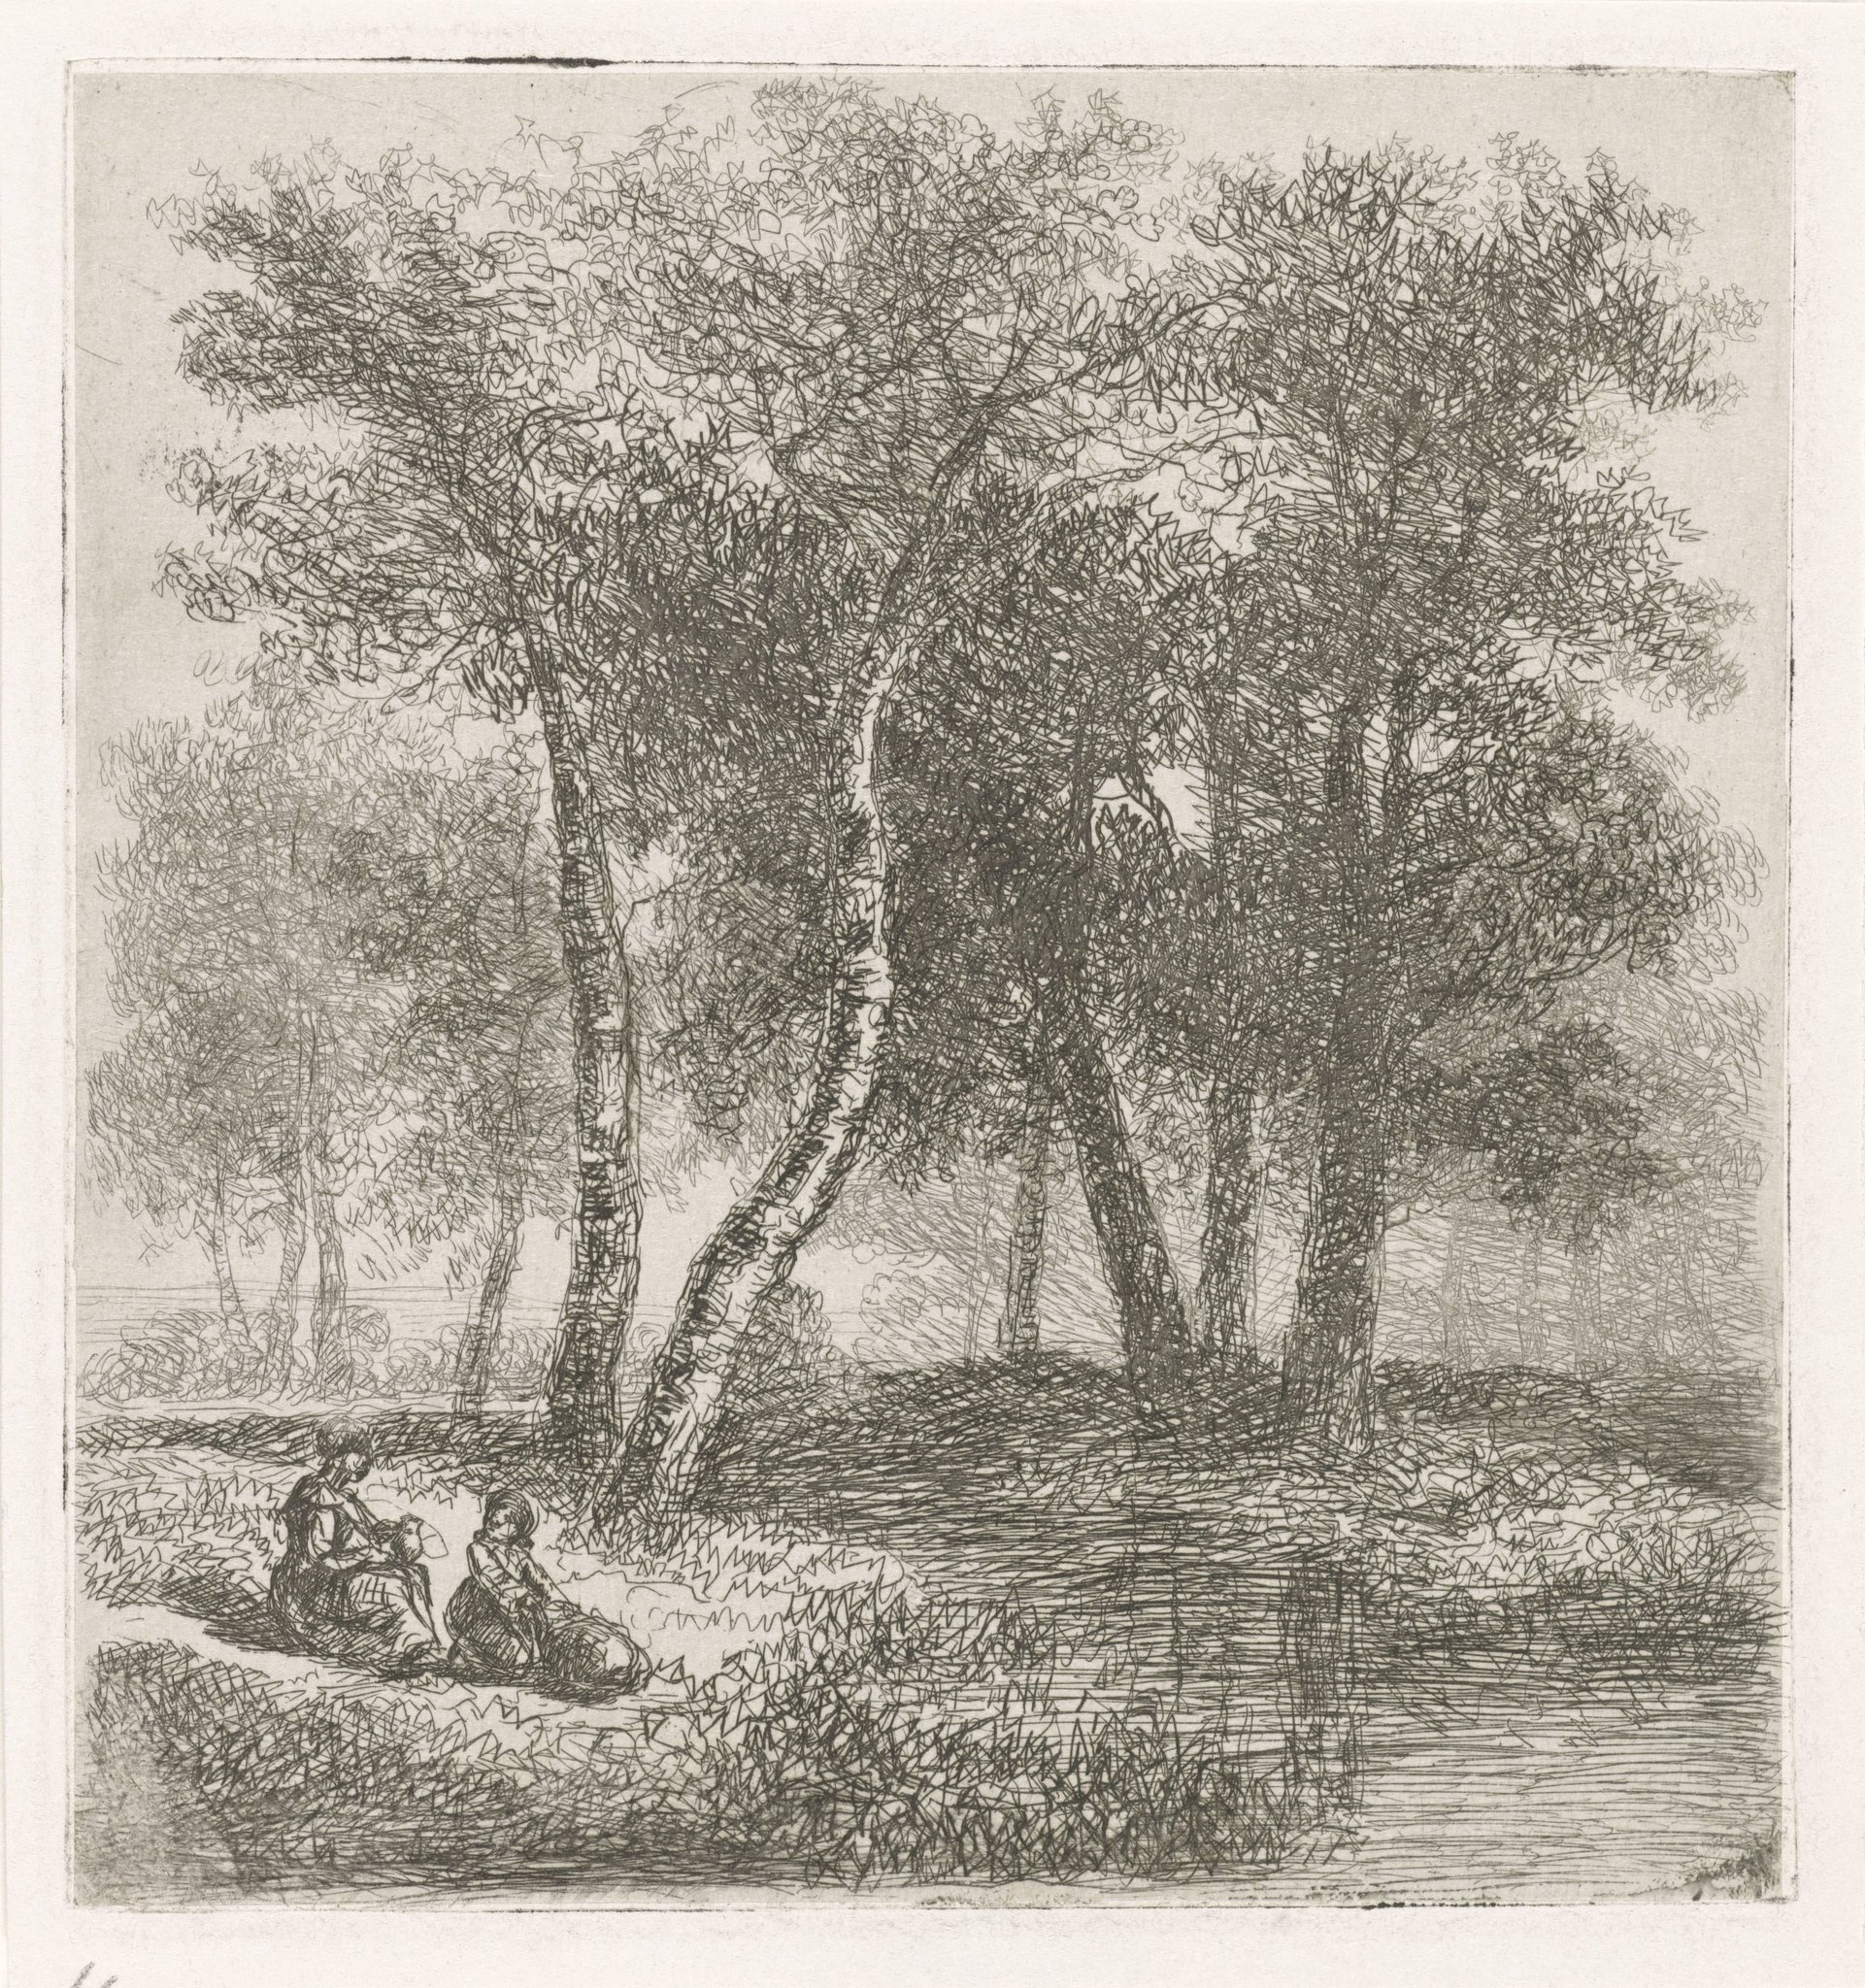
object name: print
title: Moeder en kind aan de waterkant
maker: hermanus jan hendrik van rijkelijkhuysen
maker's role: painter, print maker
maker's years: 1813-1883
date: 1823-1883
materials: paper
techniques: drypoint, etching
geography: utrecht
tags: swamp, inland marsh, fens (+ landscape with figures, staffage), mother and baby or young child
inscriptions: collector's mark: Lugt 2228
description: In een bos zitten een moeder en haar kind aan de rand van een ven.